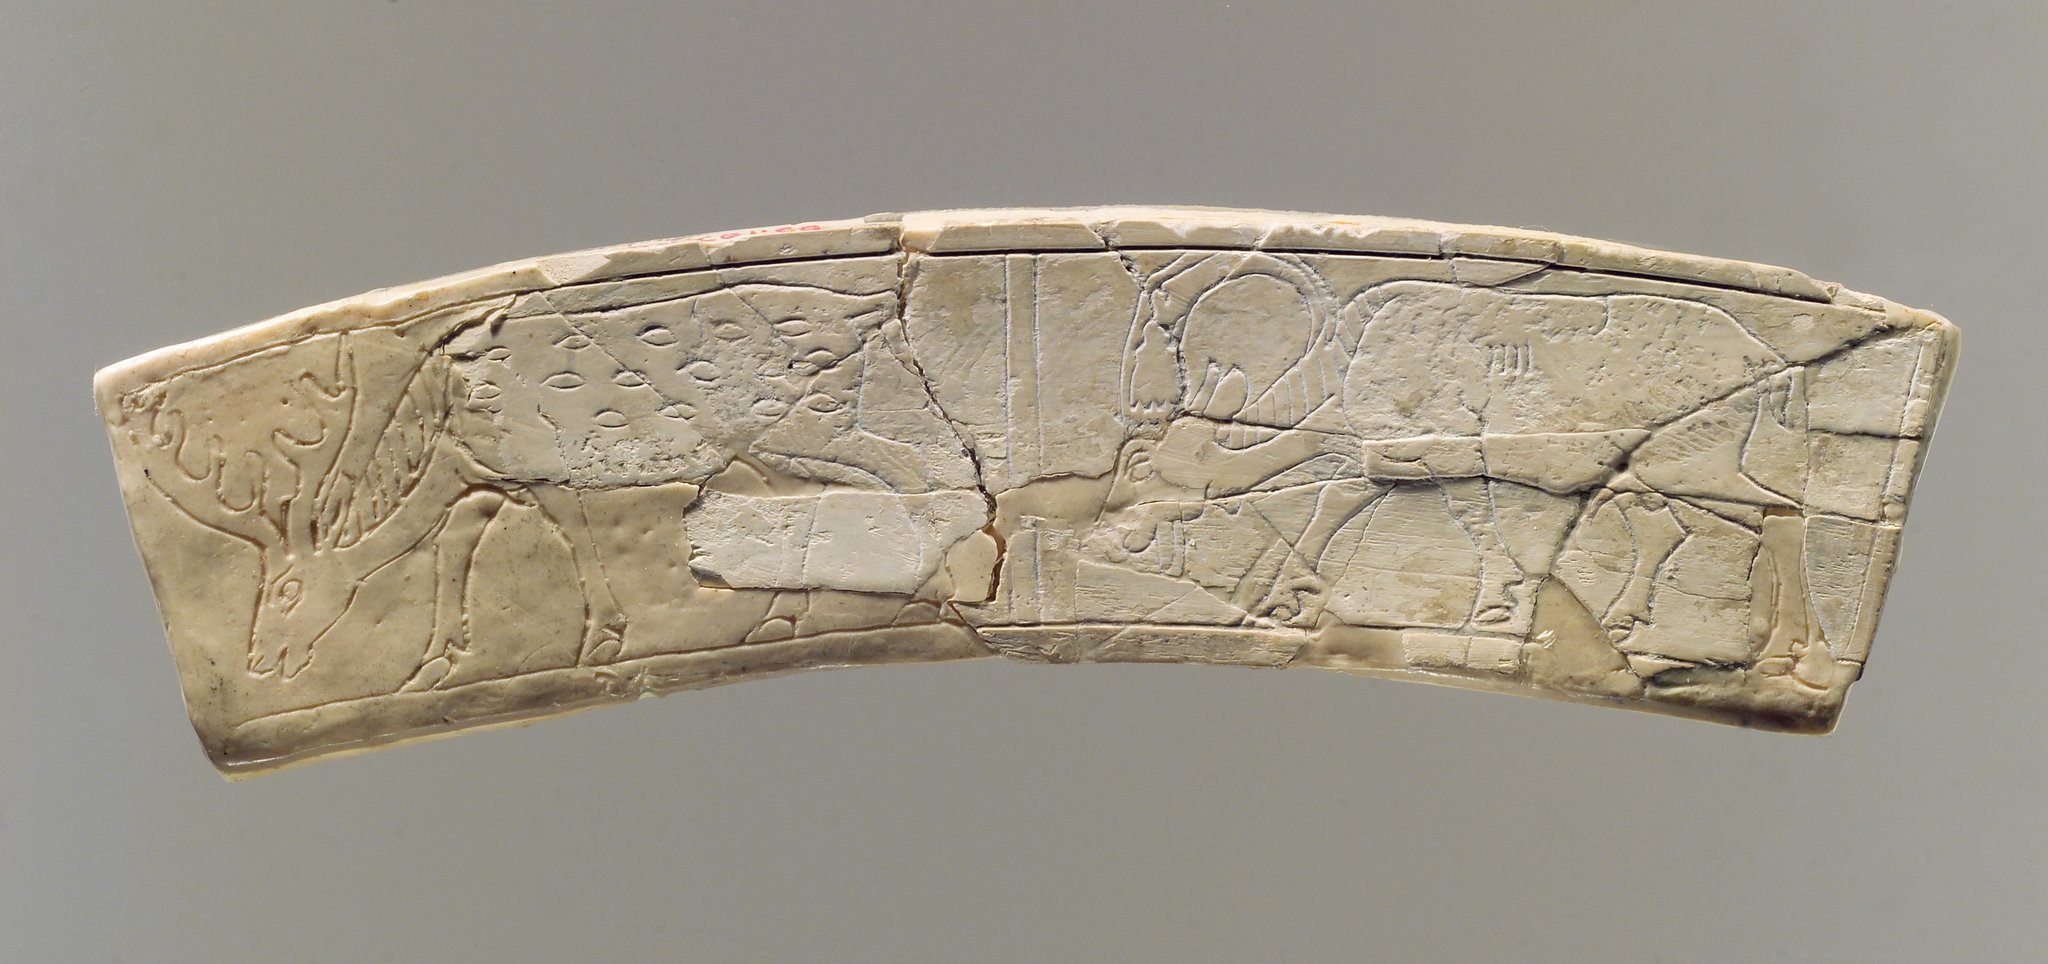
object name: plaque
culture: assyrian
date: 900-701 BCE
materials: ivory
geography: mesopotamia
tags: deer